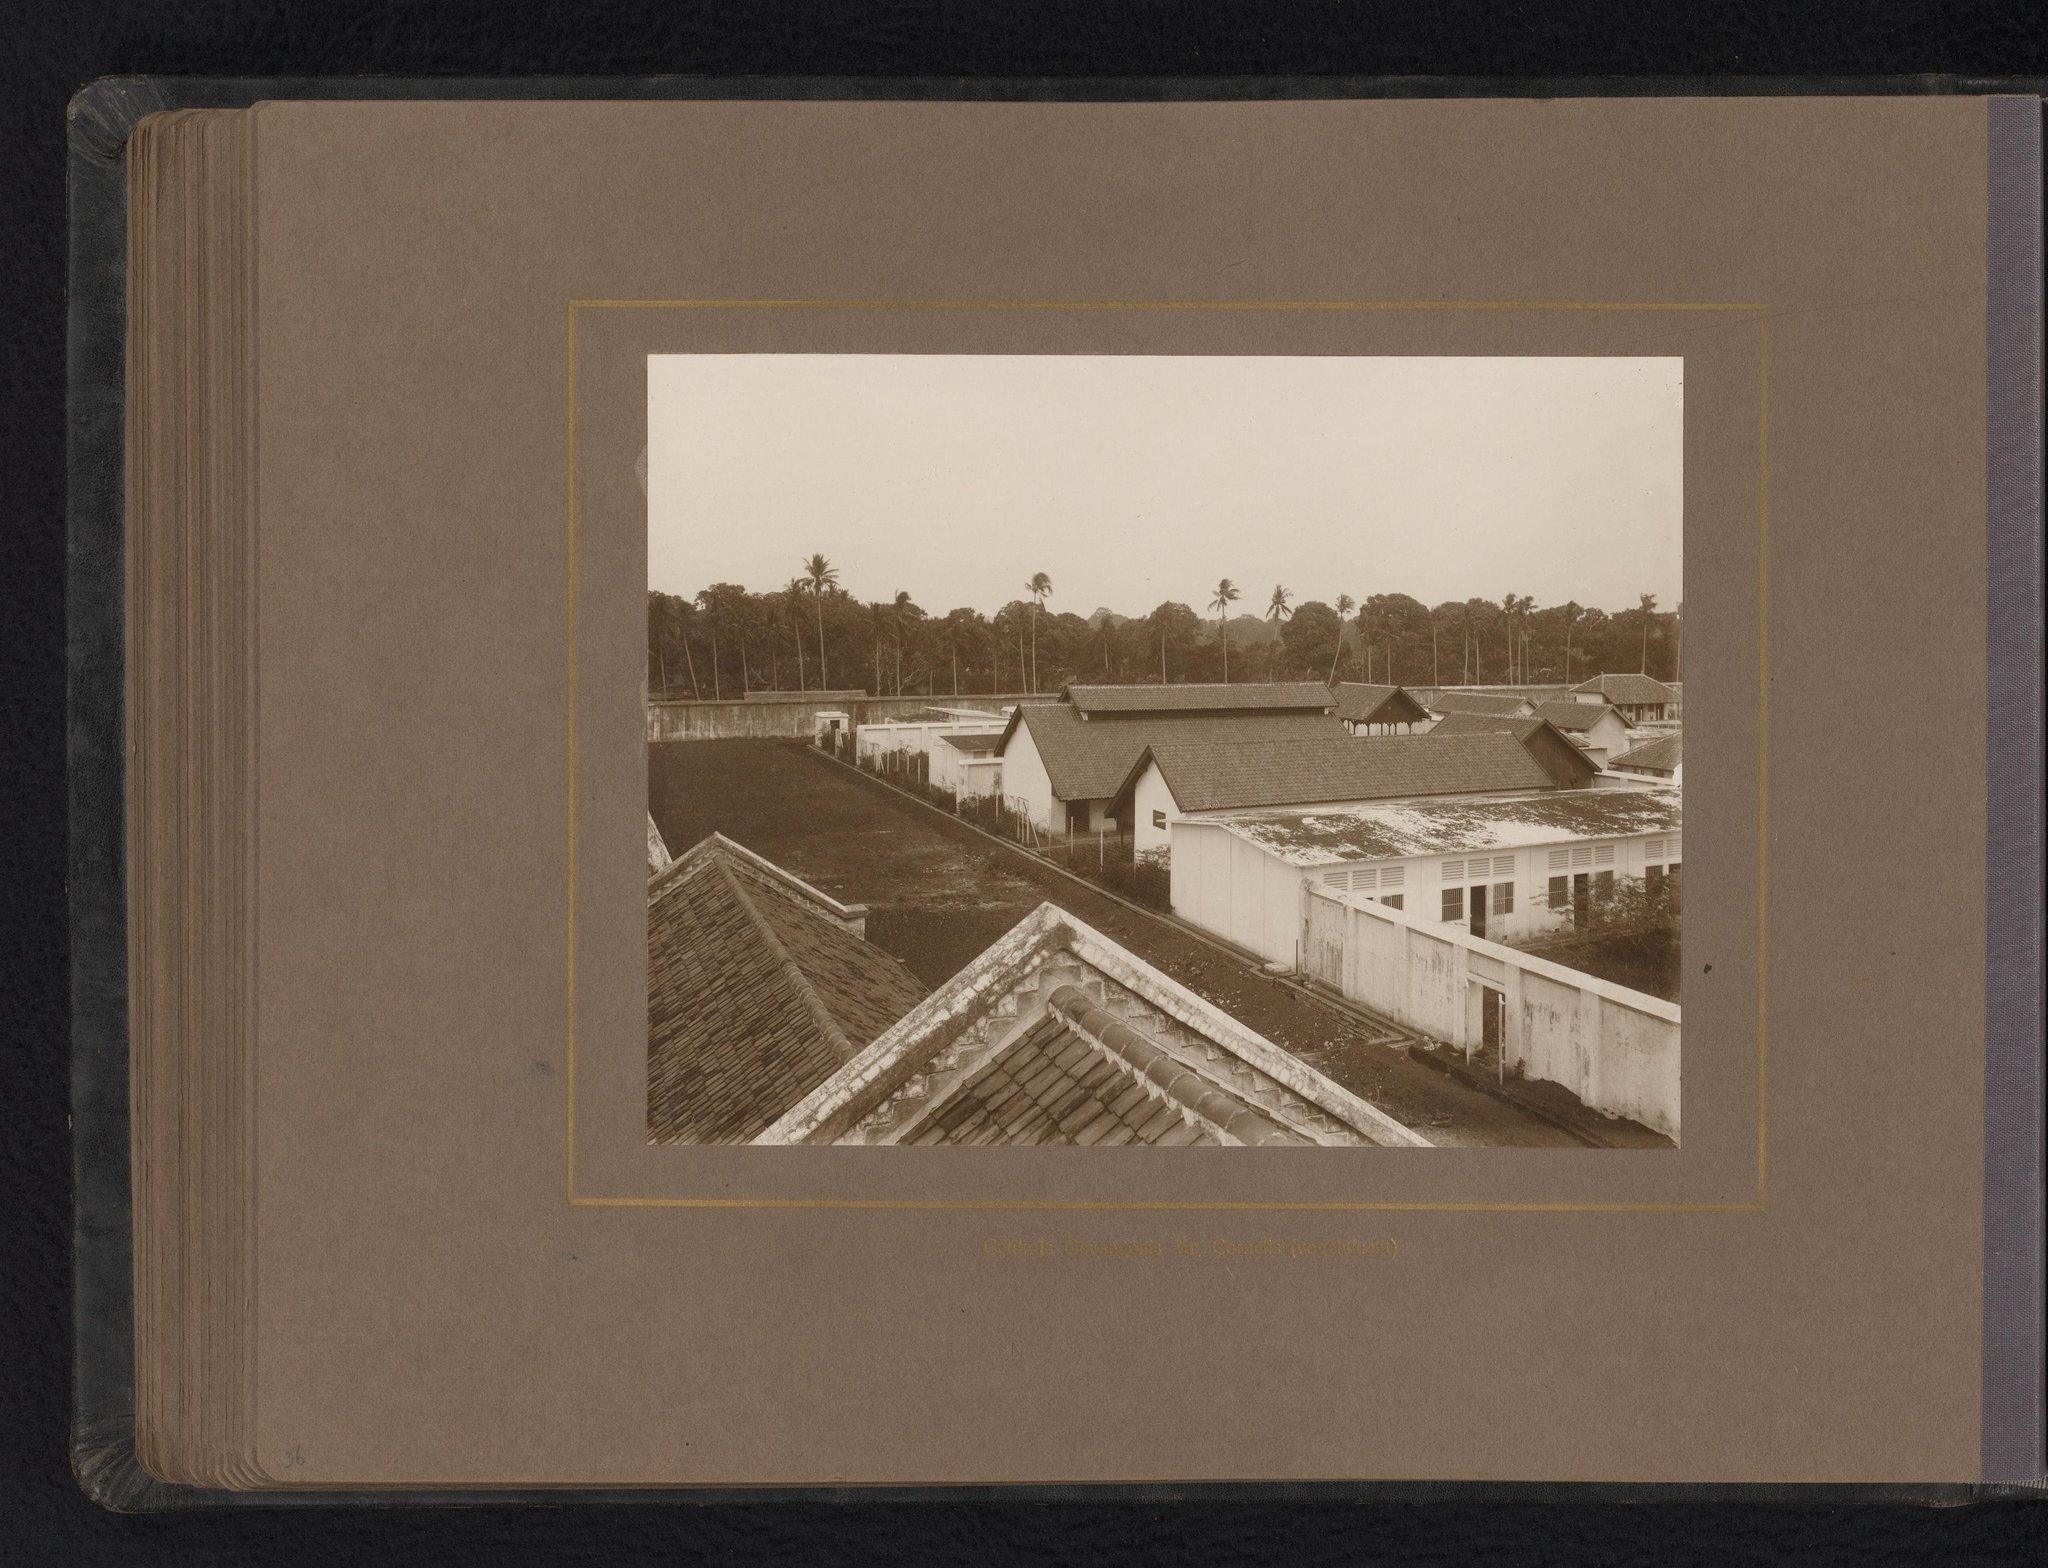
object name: photograph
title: Centrale Gevangenis Mr. Cornelis (vogelvlucht)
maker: Anonymous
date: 1918-1919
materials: photographic support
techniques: gelatin silver print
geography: batavia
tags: prison, jail, batavia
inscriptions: inscription: ‘Centrale Gevangenis Mr. Cornelis (vogelvlucht)’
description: De centrale gevangenis in de wijk Meester Cornelis in Batavia. Gezicht op de gebouwen in vogelvlucht. Onderdeel van het fotoalbum van de Eerste Waterstaatsafdeling op West-Java 22 maart 1915 - 30 juli 1919.